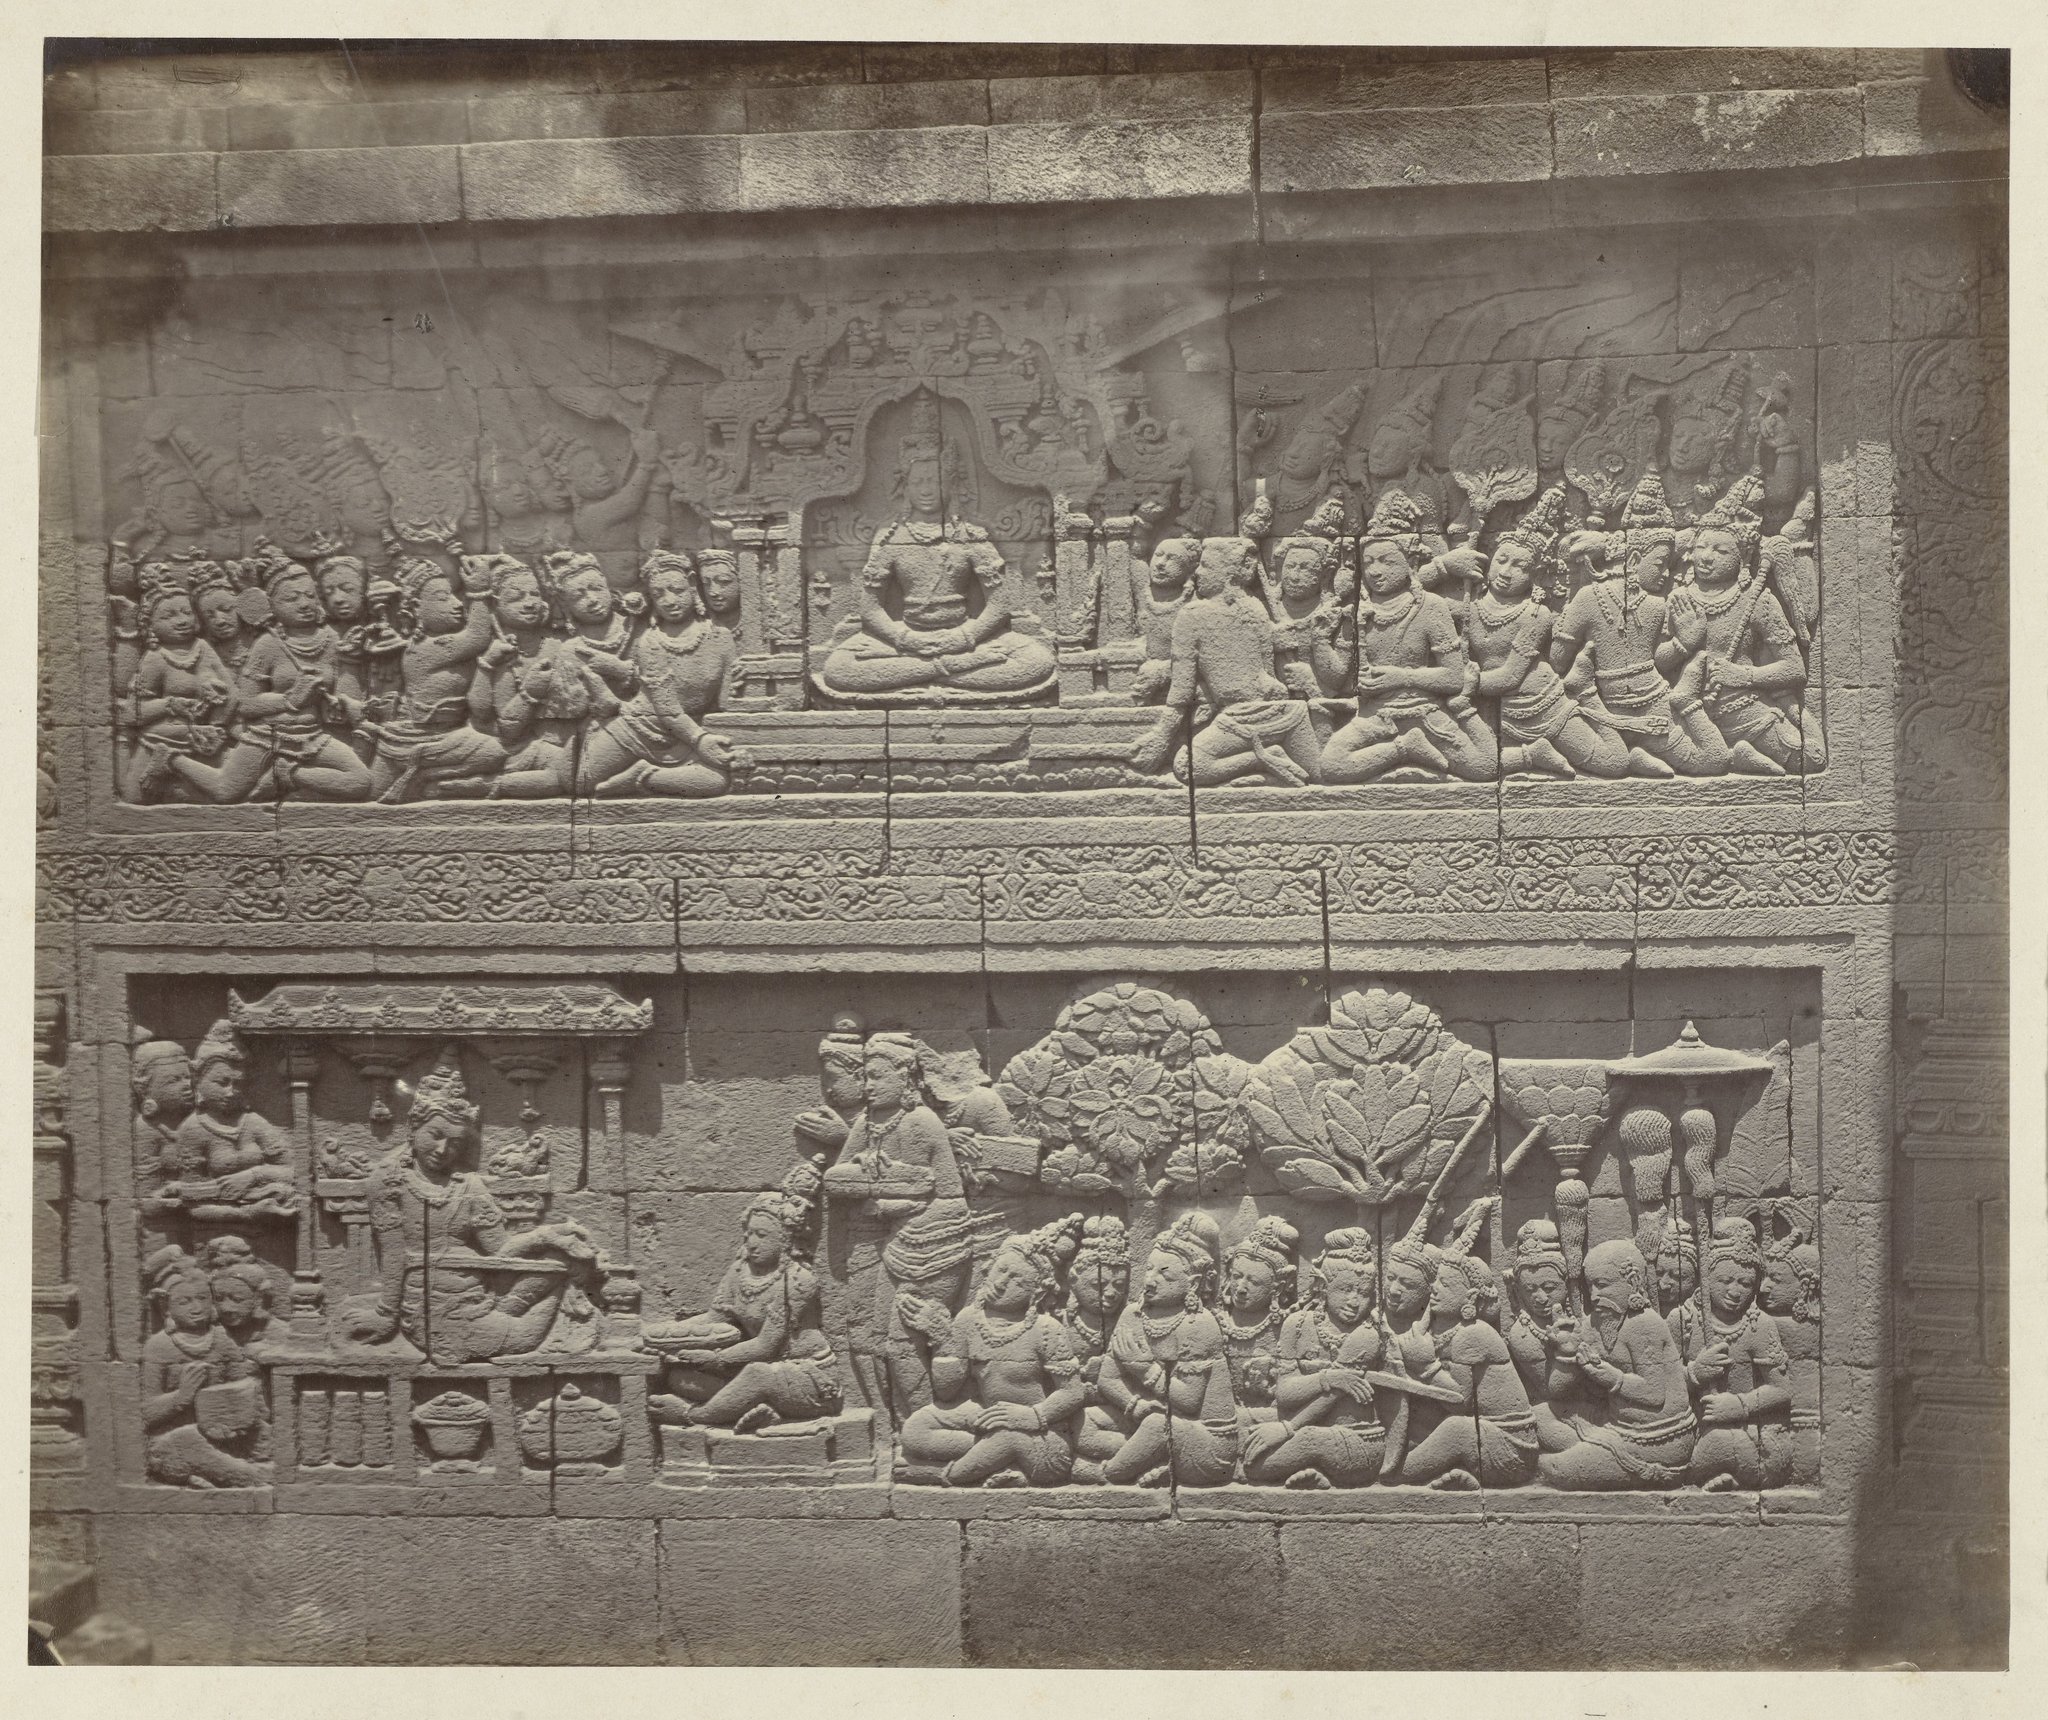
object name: photograph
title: Idem 2e gaanderij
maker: isidore kinsbergen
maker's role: fotograaf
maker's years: 1821-1905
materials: cardboard, paper, photographic support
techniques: albumen print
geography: java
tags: borobudur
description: Gallery I, main wall, east side 15 (top): Relief 1a-12, Lalitavistara relief, The descent of Bodhisattva from the Tusita heaven. 15 (bottom): relief 1b-12, Avadana relief, Manohora story, Sudhana brings the tribute of the rebels to his father. Borobudur village, Magelang district, Central Java province, 778-824 AD.